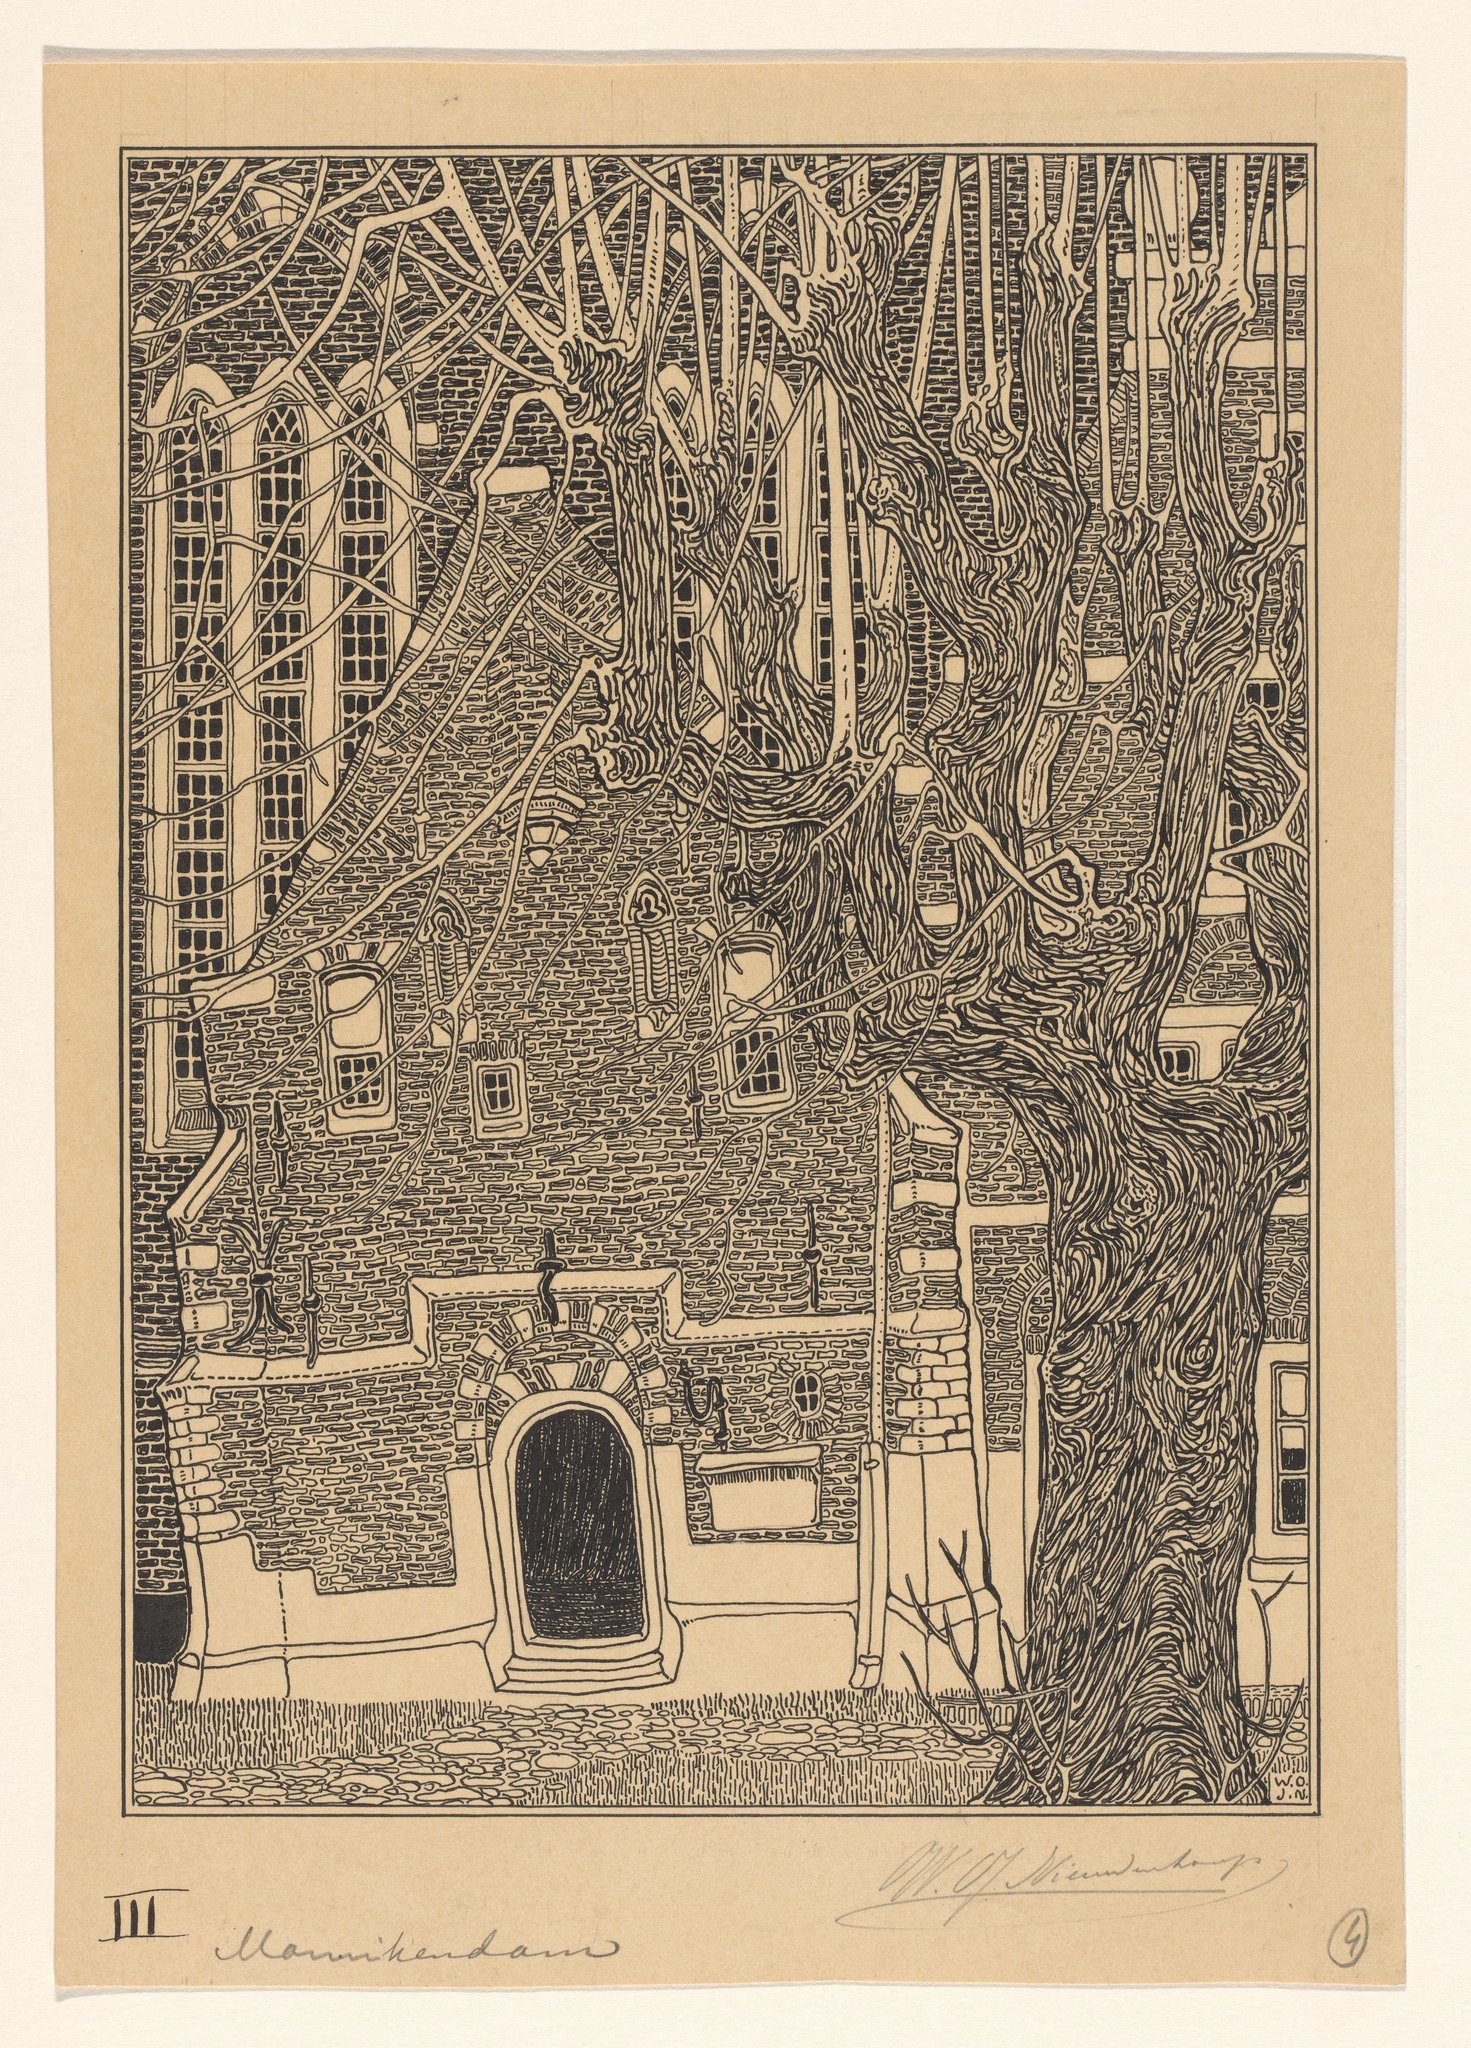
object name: boekillustratie ontwerp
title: Ingang van de Grote of Sint-Nicolaaskerk te Monnickendam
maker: wijnand otto jan nieuwenkamp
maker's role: draughtsman, print maker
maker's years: 1874-1950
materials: ink, paper, pencil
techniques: pen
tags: church (exterior)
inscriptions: number: ‘4’, inscription: ‘Monnikendam’, inscription: ‘Entrance of the church at Monnickendam/ [...] "old dutch town of/ [...] Zuiderzee" [...]/ (N.Holland)’, number: ‘III’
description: Ontwerp voor een boekillustratie voor: Nieuwenkamp, W.O.J. en Veldheer, J.G. Oude Hollandsche steden aan de Zuiderzee. Haarlem: De Erven F. Bohn, 1897. De tekening is niet opgenomen in de publicatie, de sterk gelijkende tekening RP-T-1930-117 wél.